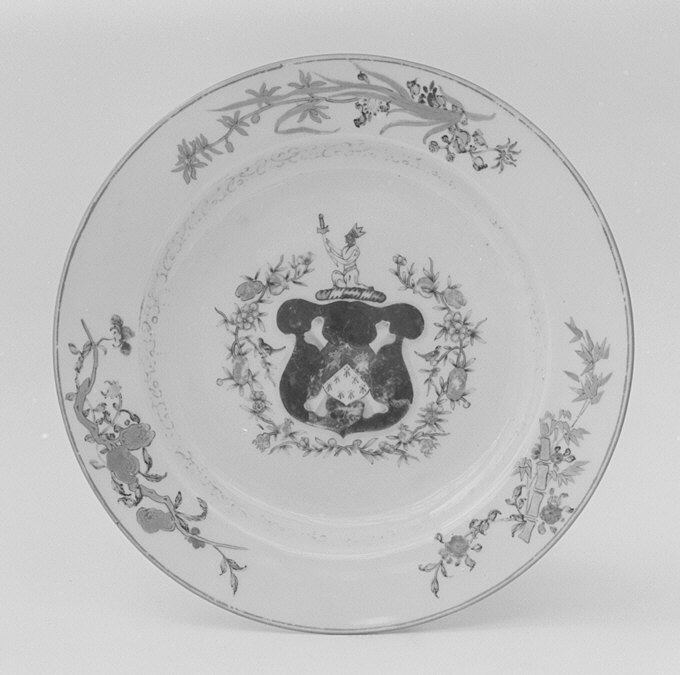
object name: plate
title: Plate (part of a service)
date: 1740-1750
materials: hard paste porcelain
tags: men,flowers,coat of arms